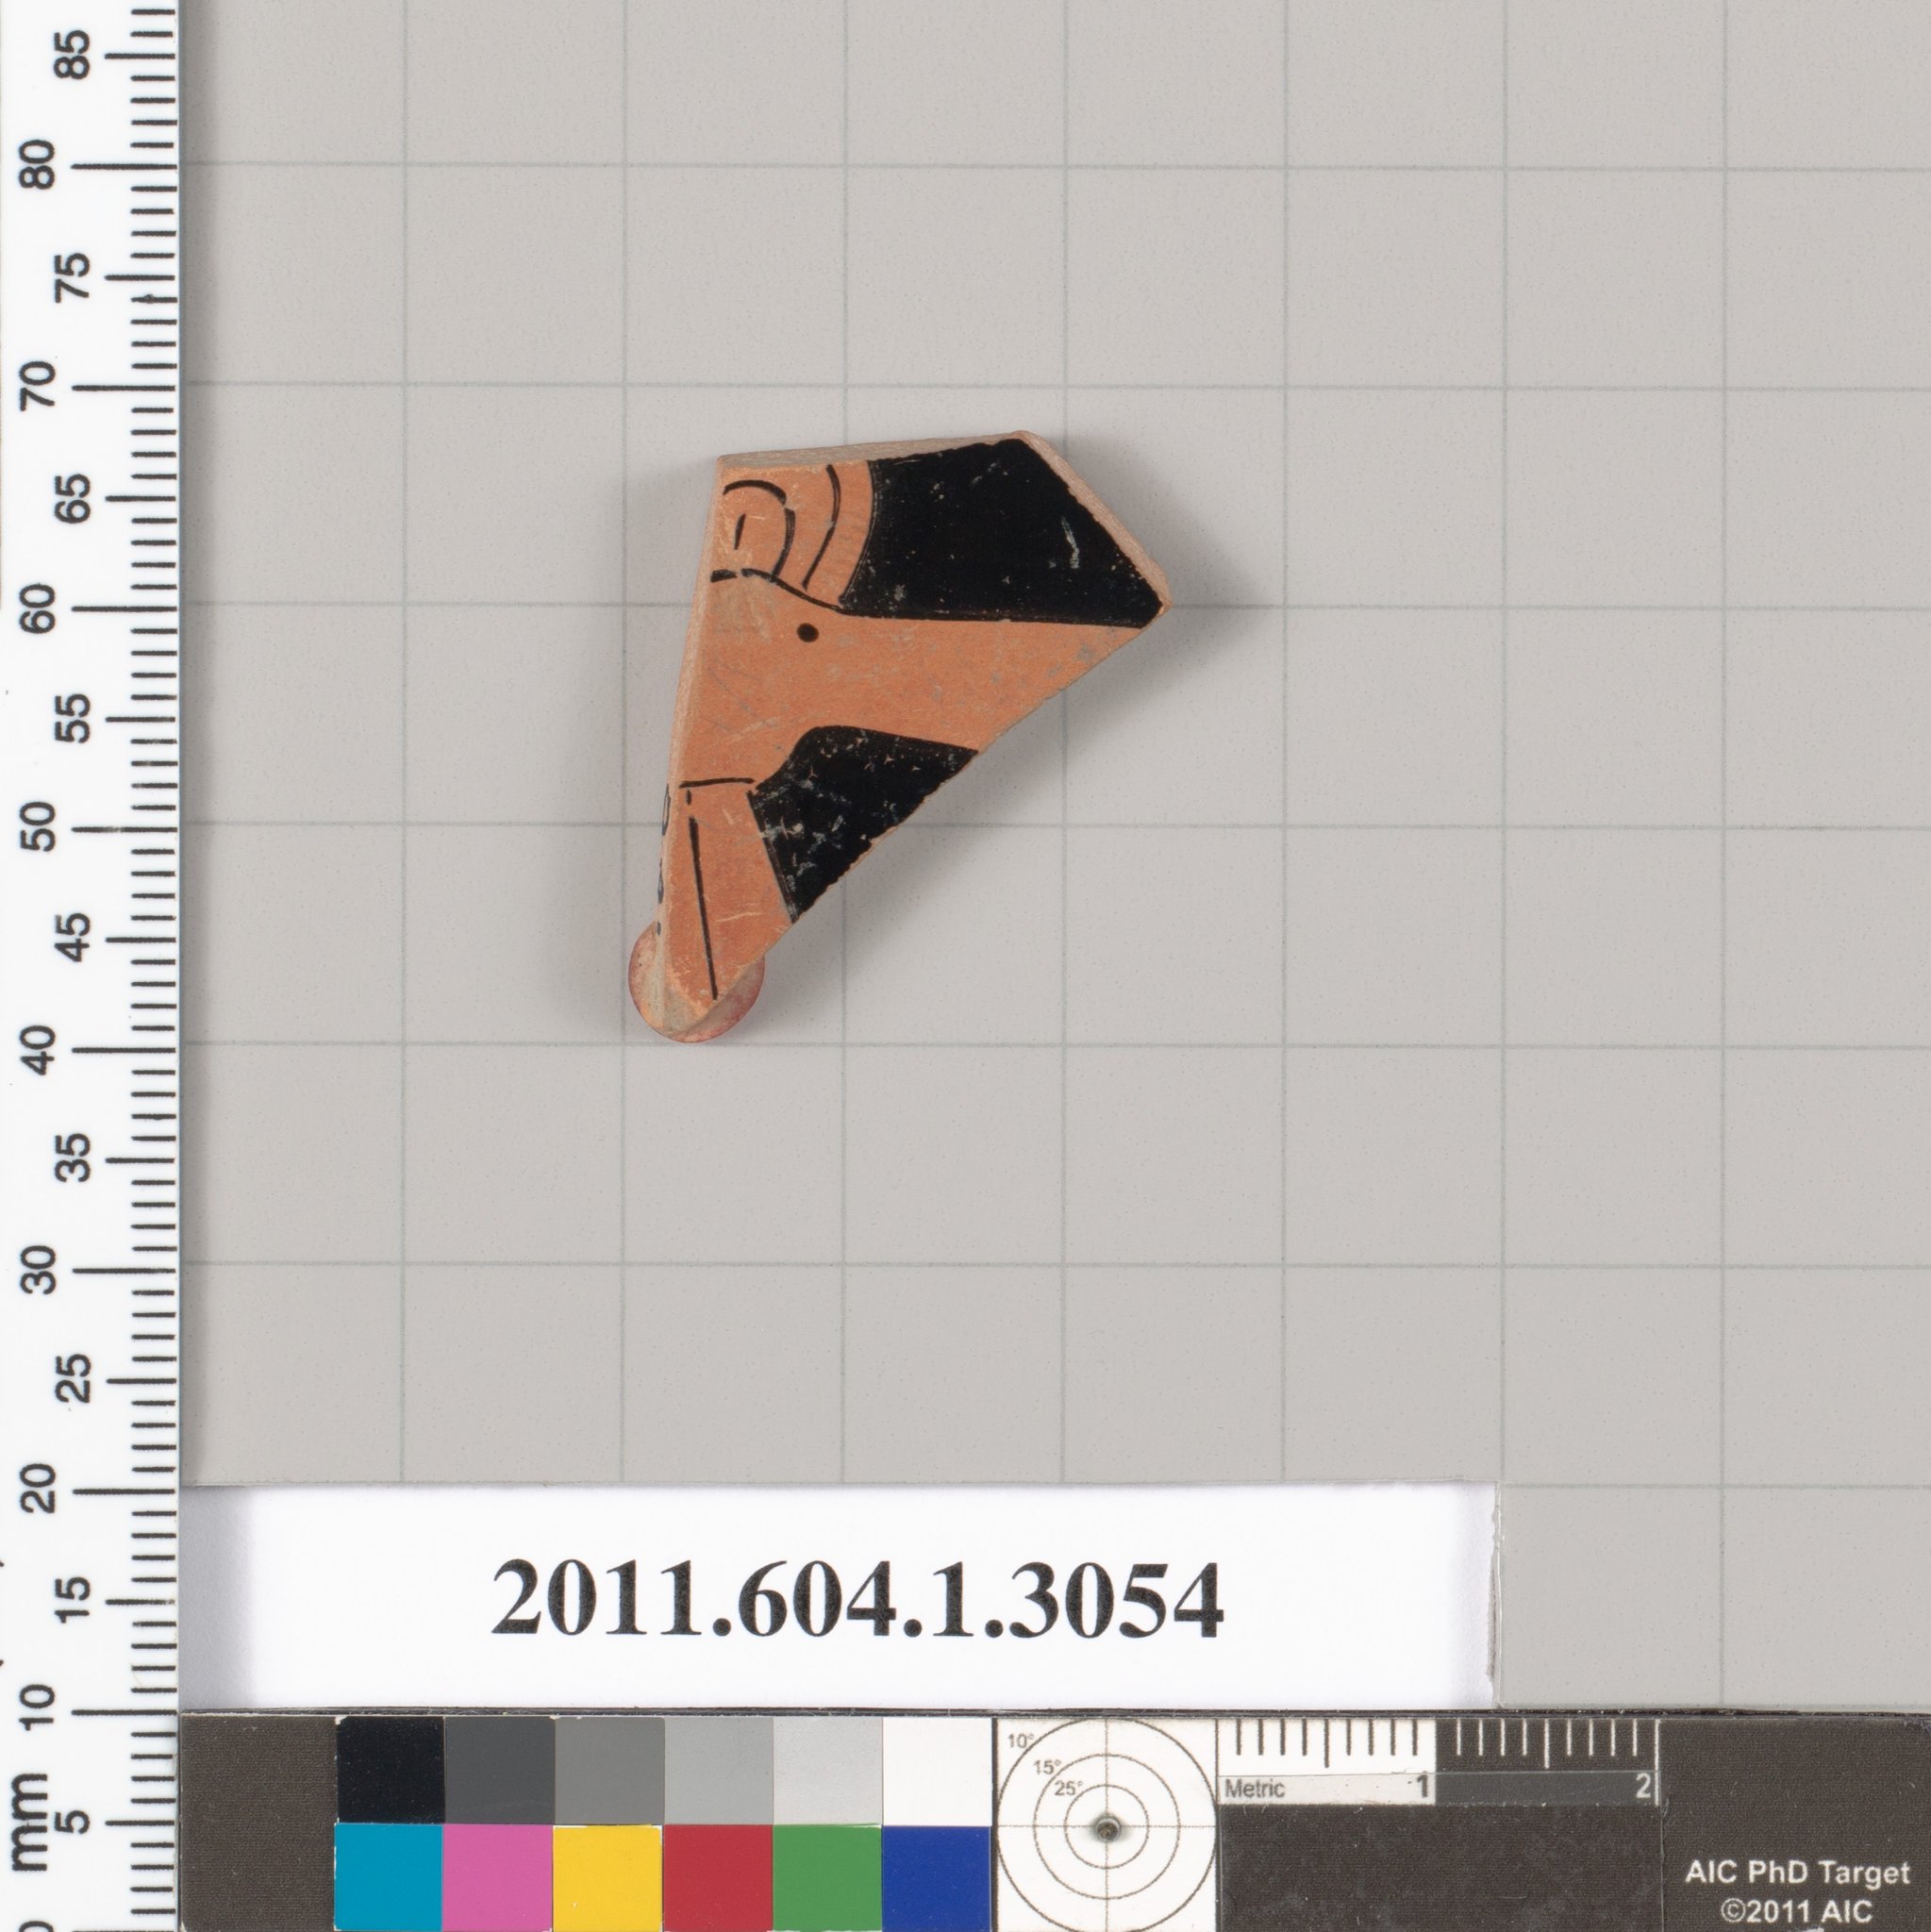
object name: kylix fragment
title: Terracotta fragment of a kylix (drinking cup)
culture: greek, attic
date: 490-480 BCE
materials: terracotta